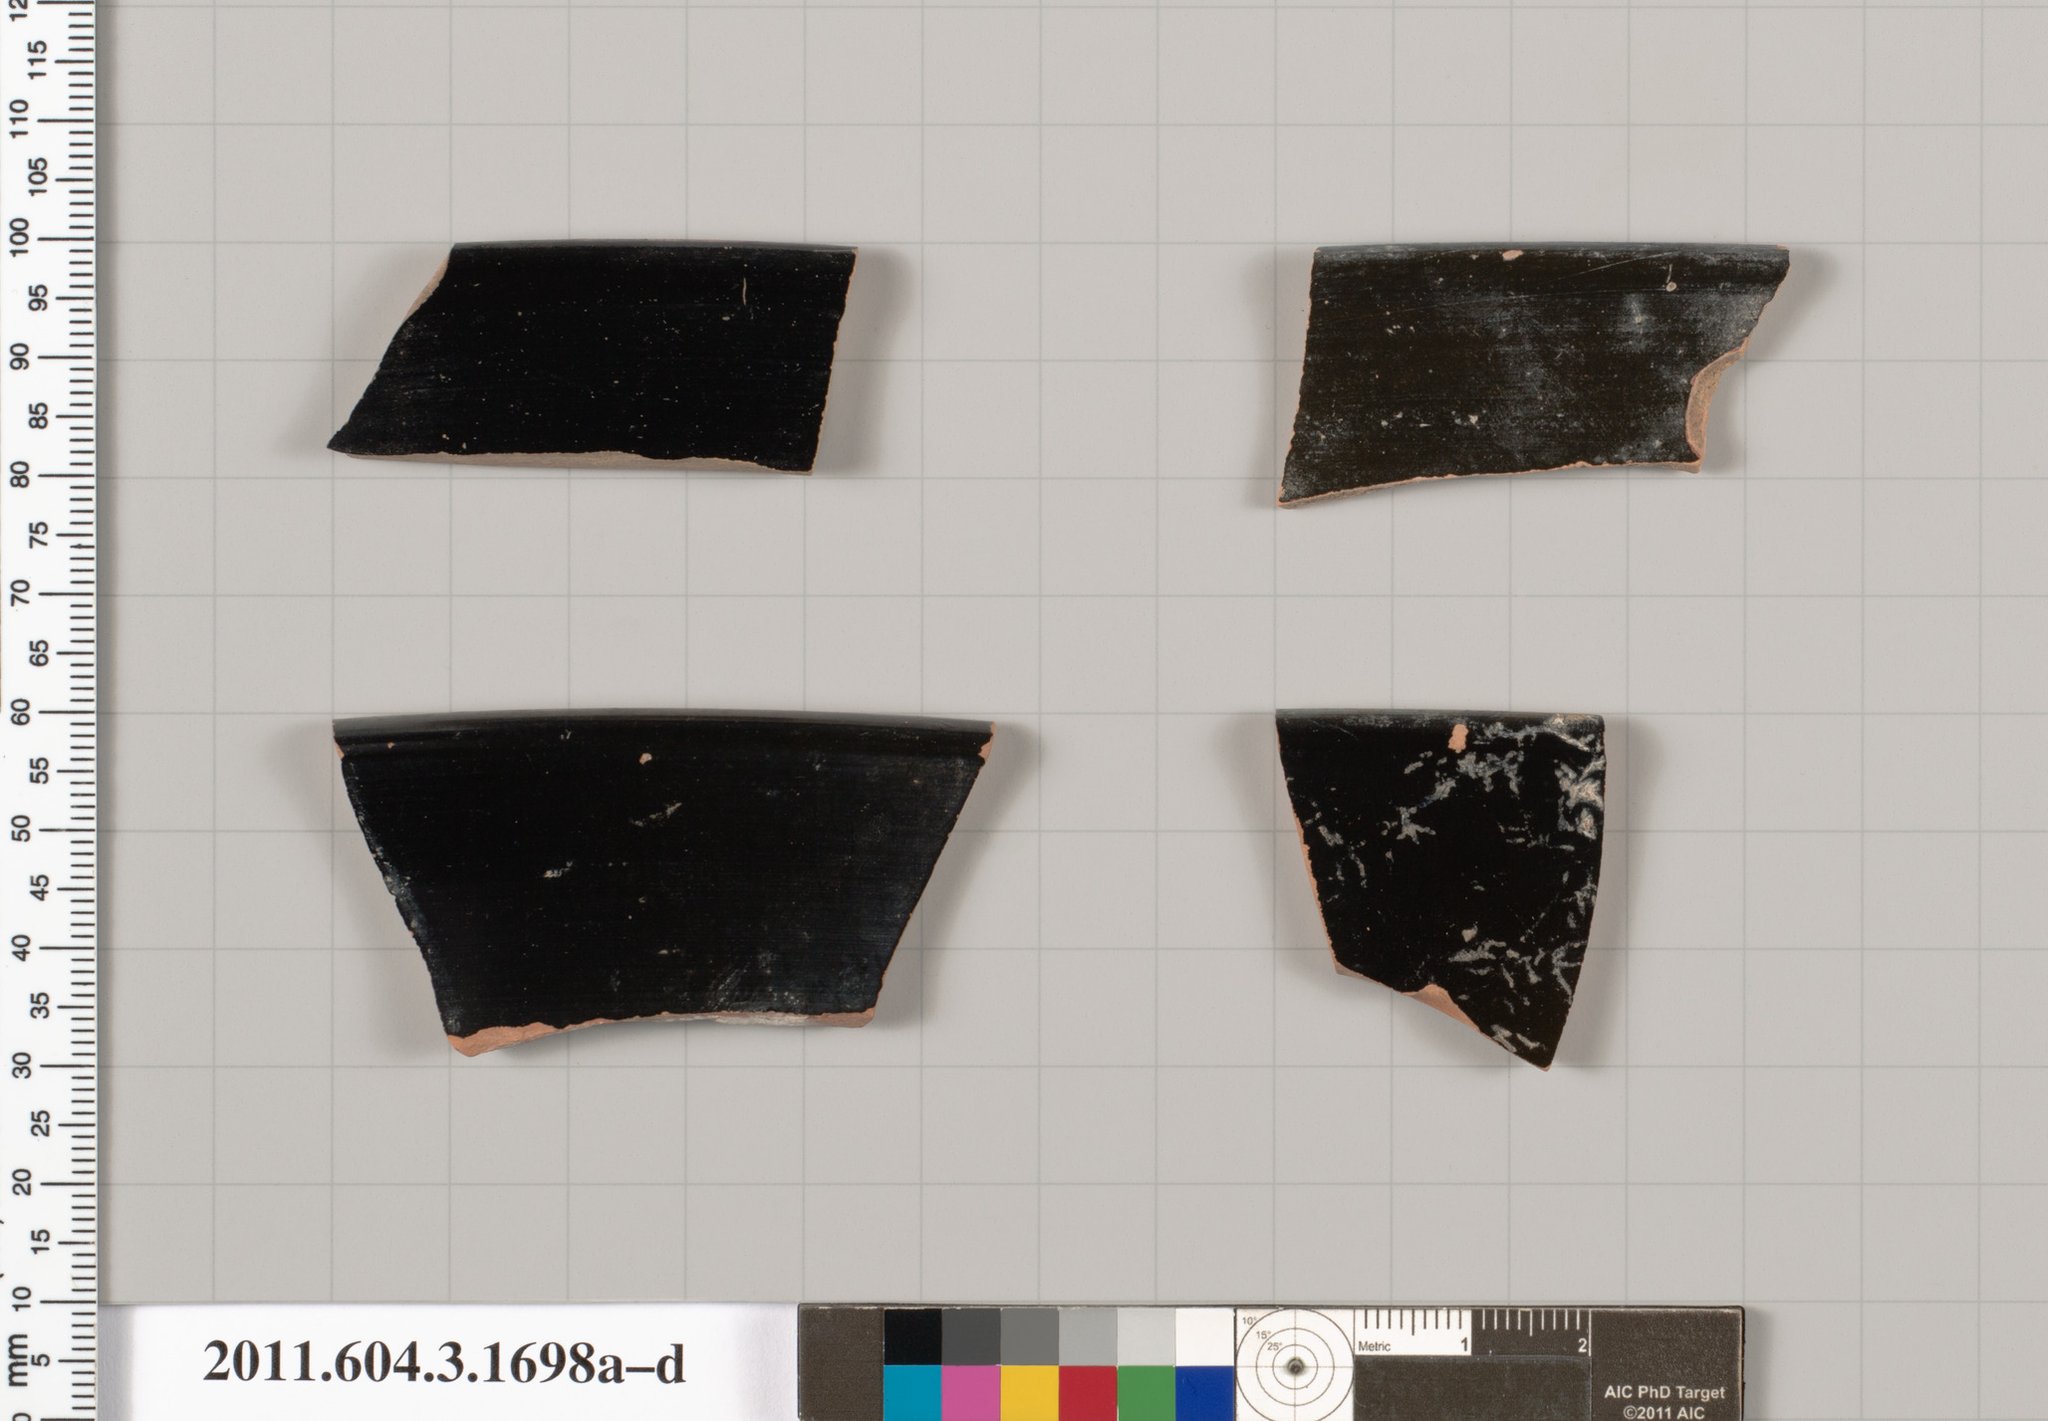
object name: kylix fragment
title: Terracotta rim fragments of kylikes: Band cups (drinking cups)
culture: greek, attic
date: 550-526 BCE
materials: terracotta